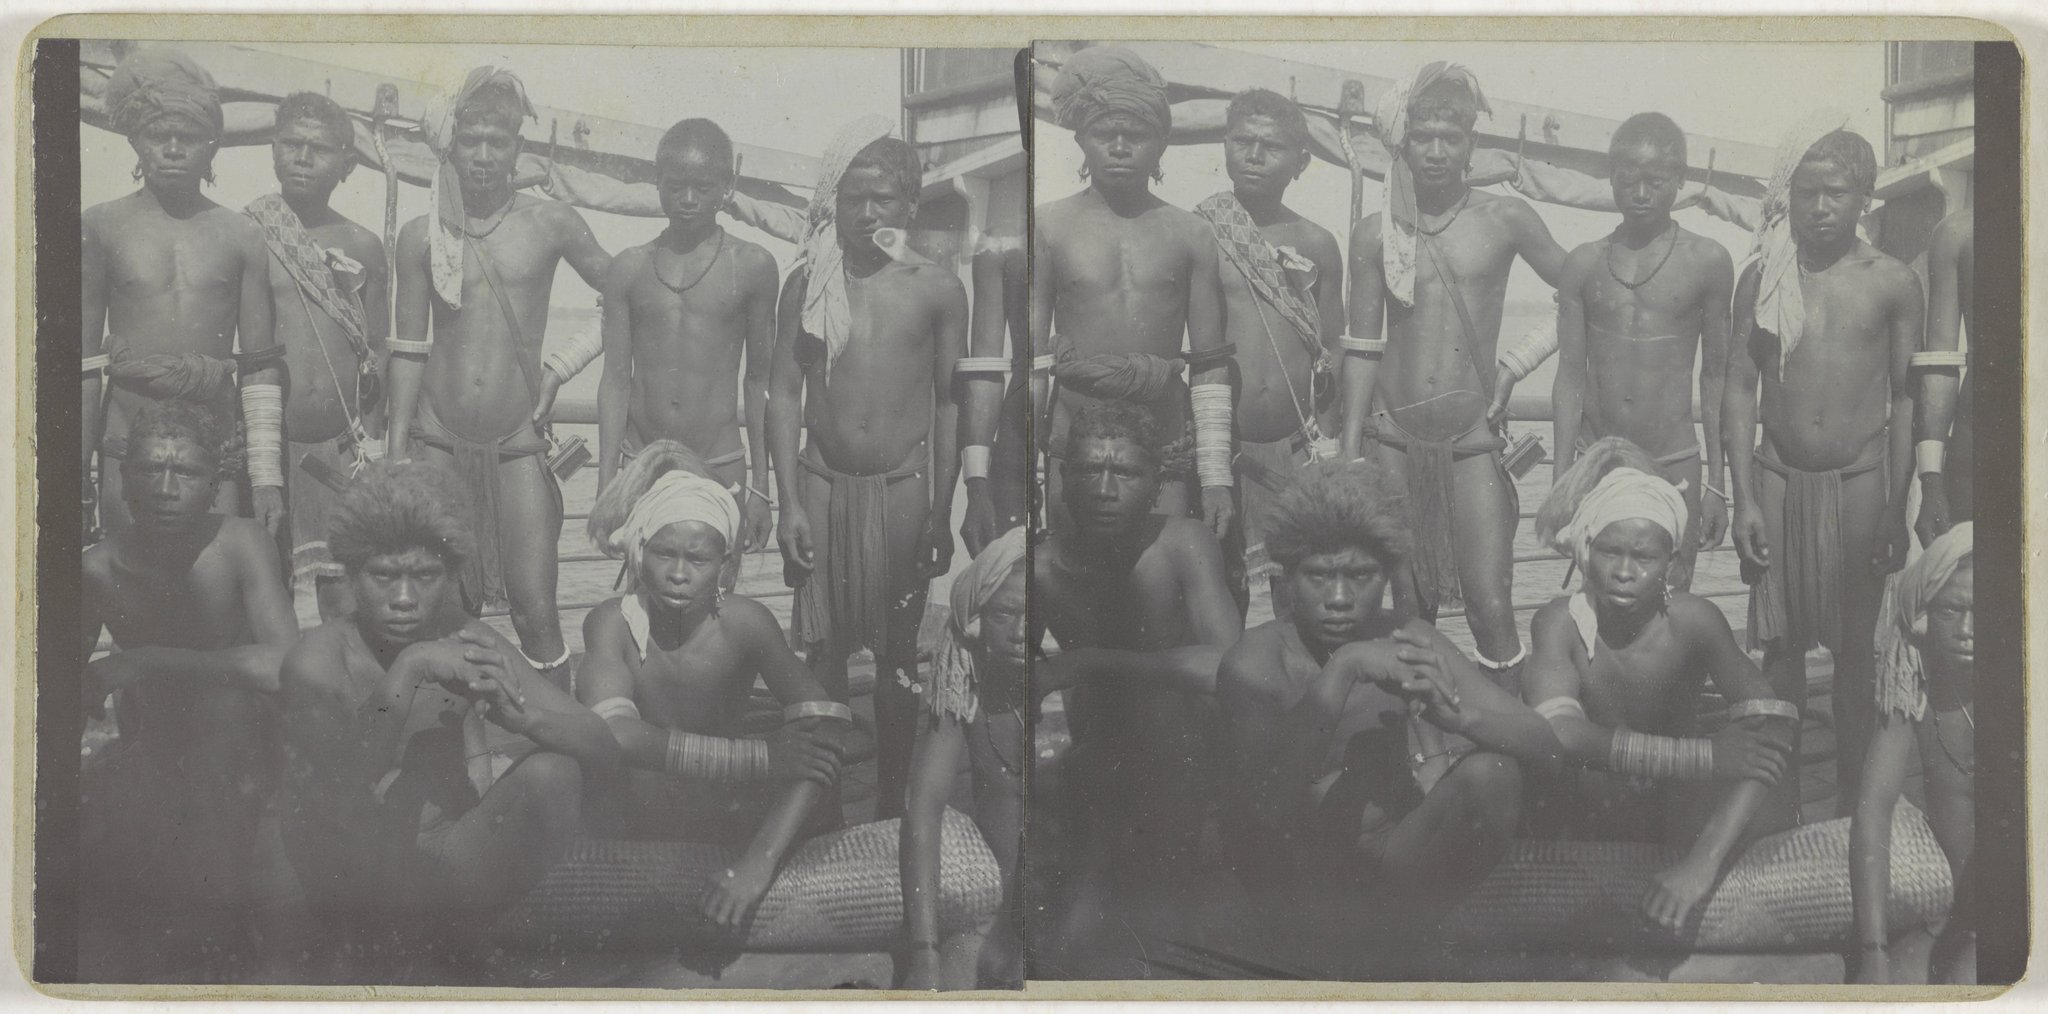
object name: stereograph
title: Tanimbar-eil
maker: Anonymous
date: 1900-1940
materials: paper, cardboard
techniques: gelatin silver print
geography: tanimbar-eilanden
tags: adult man